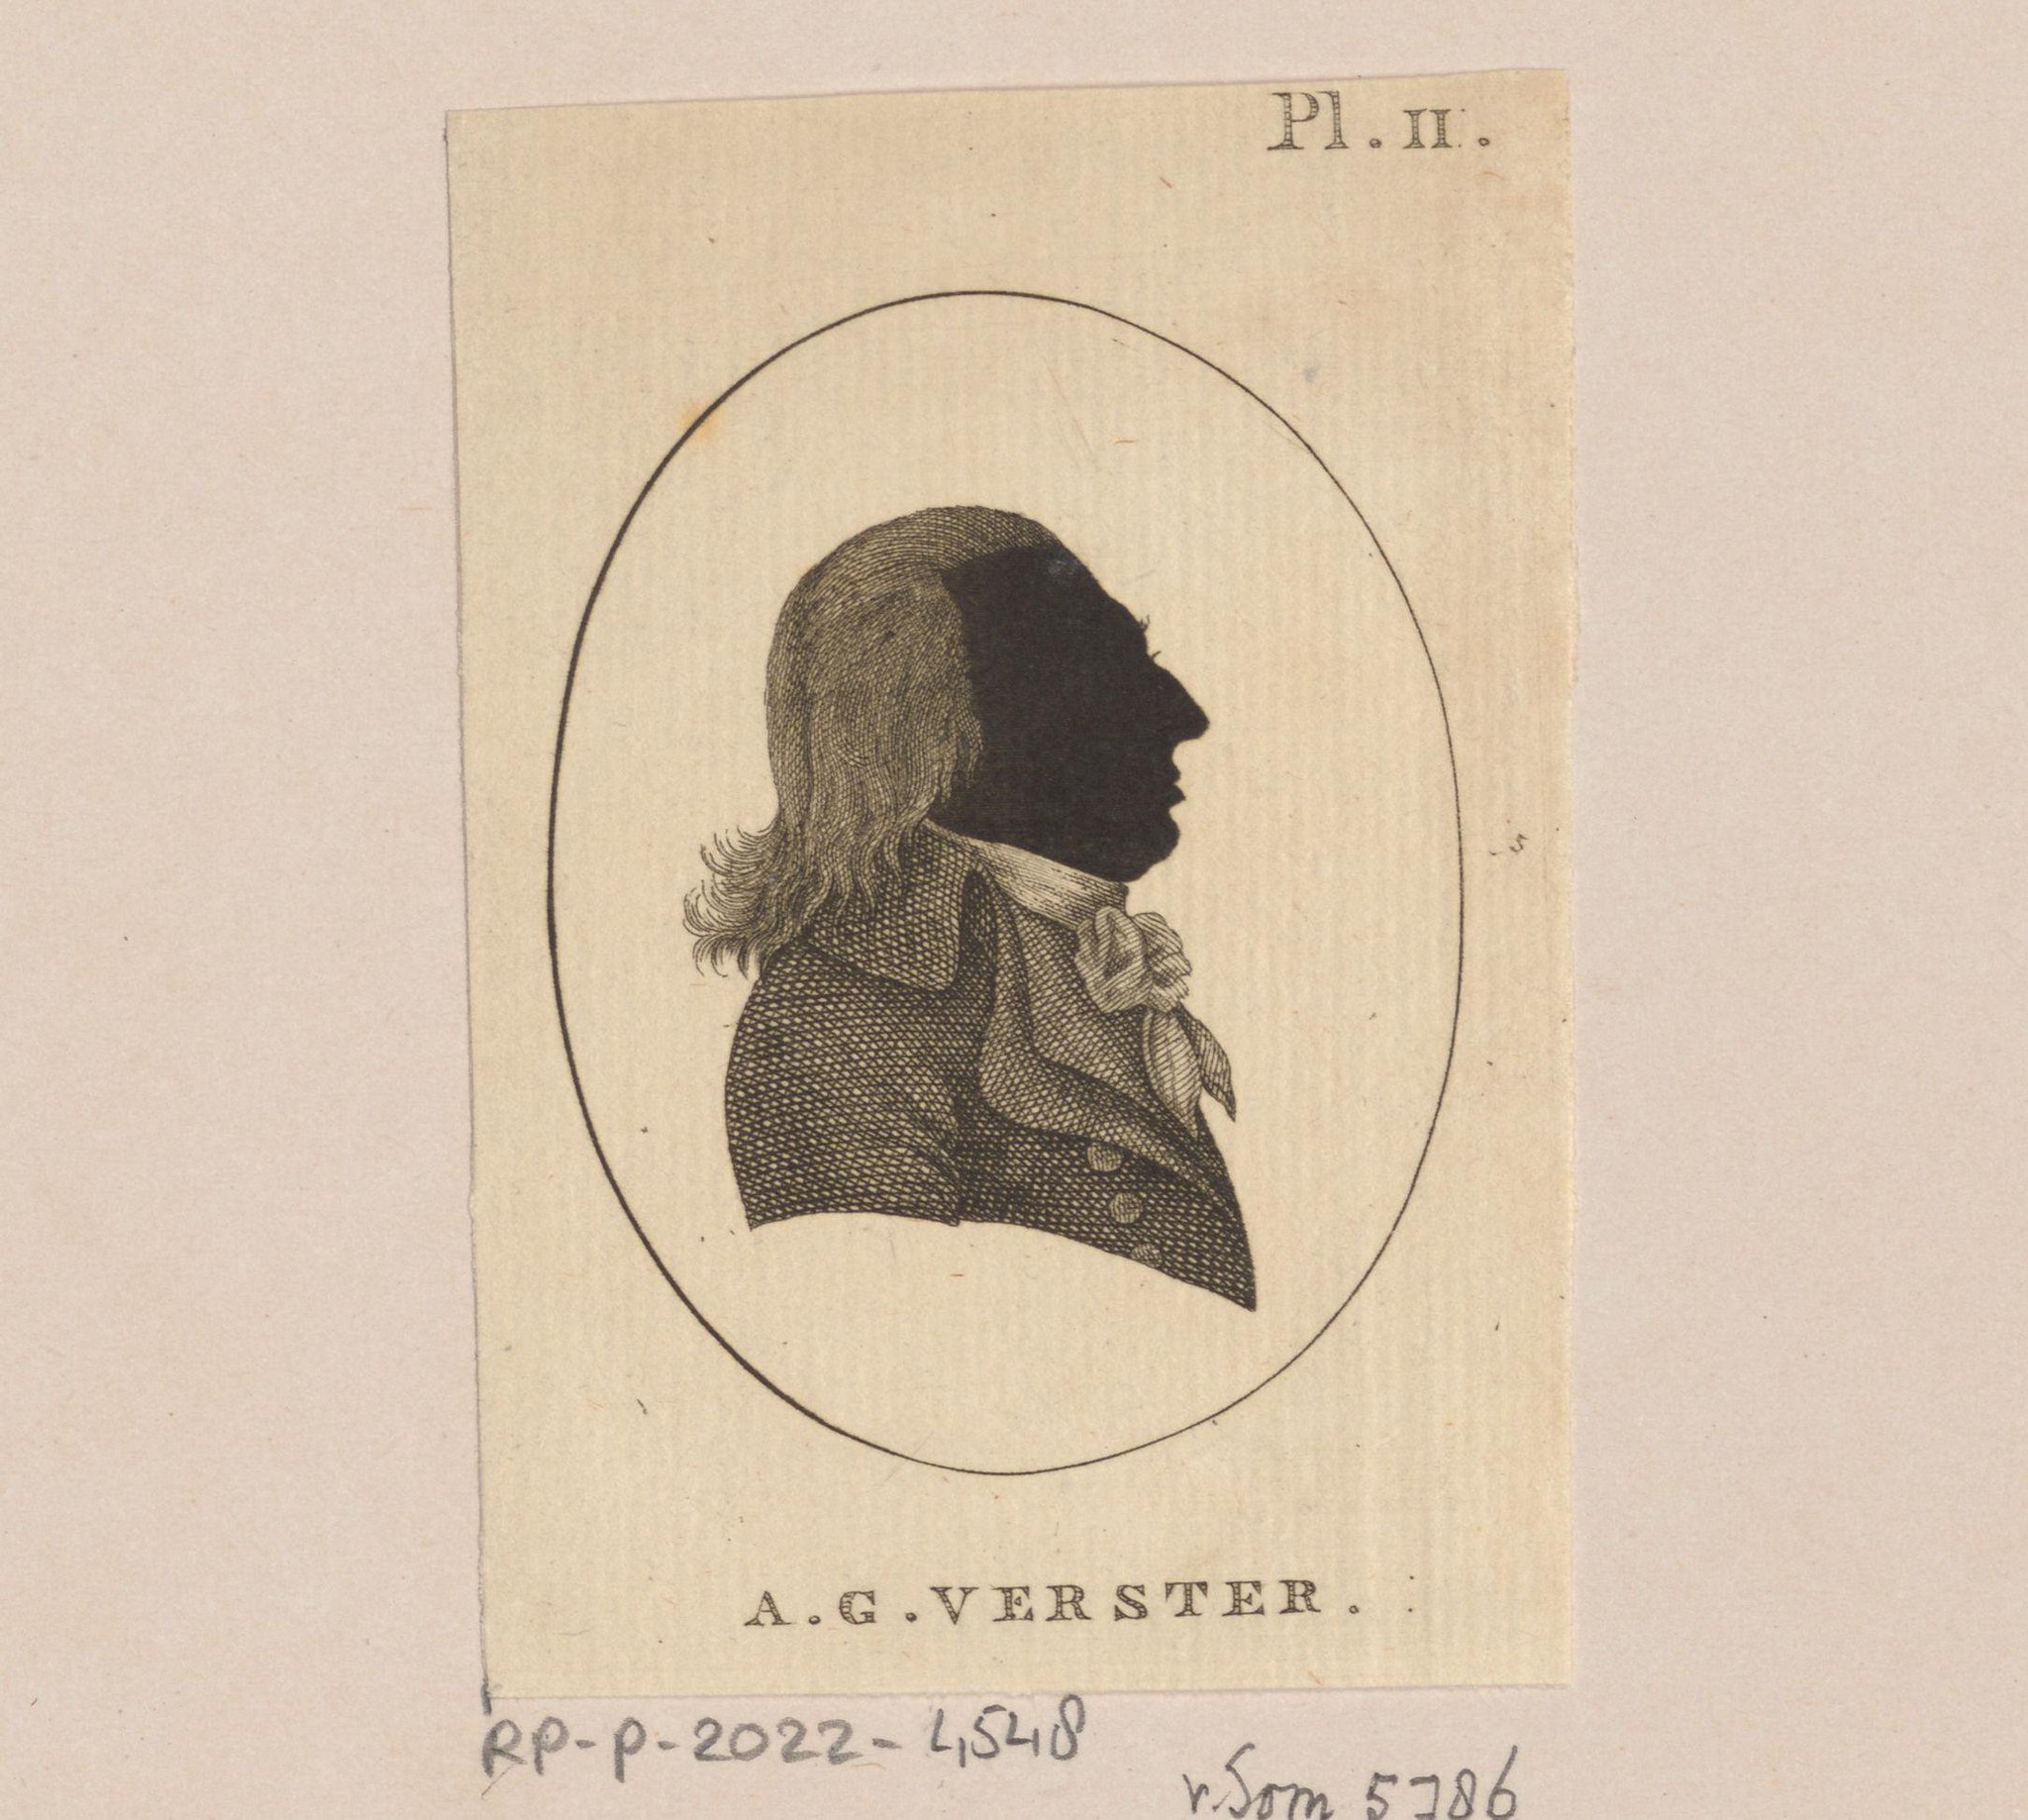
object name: print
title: Silhouetportretten van Abraham Gijsbertus Verster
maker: Anonymous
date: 1799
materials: paper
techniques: etching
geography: northern netherlands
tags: den bosch, deventer, official; civil servant; functionary (in general), historical persons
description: Prent uit: Rogge, Cornelis. Geschiedenis der staatsregeling, voor het Bataafsche volk. Amsterdam: Johannes Allart, 1799.